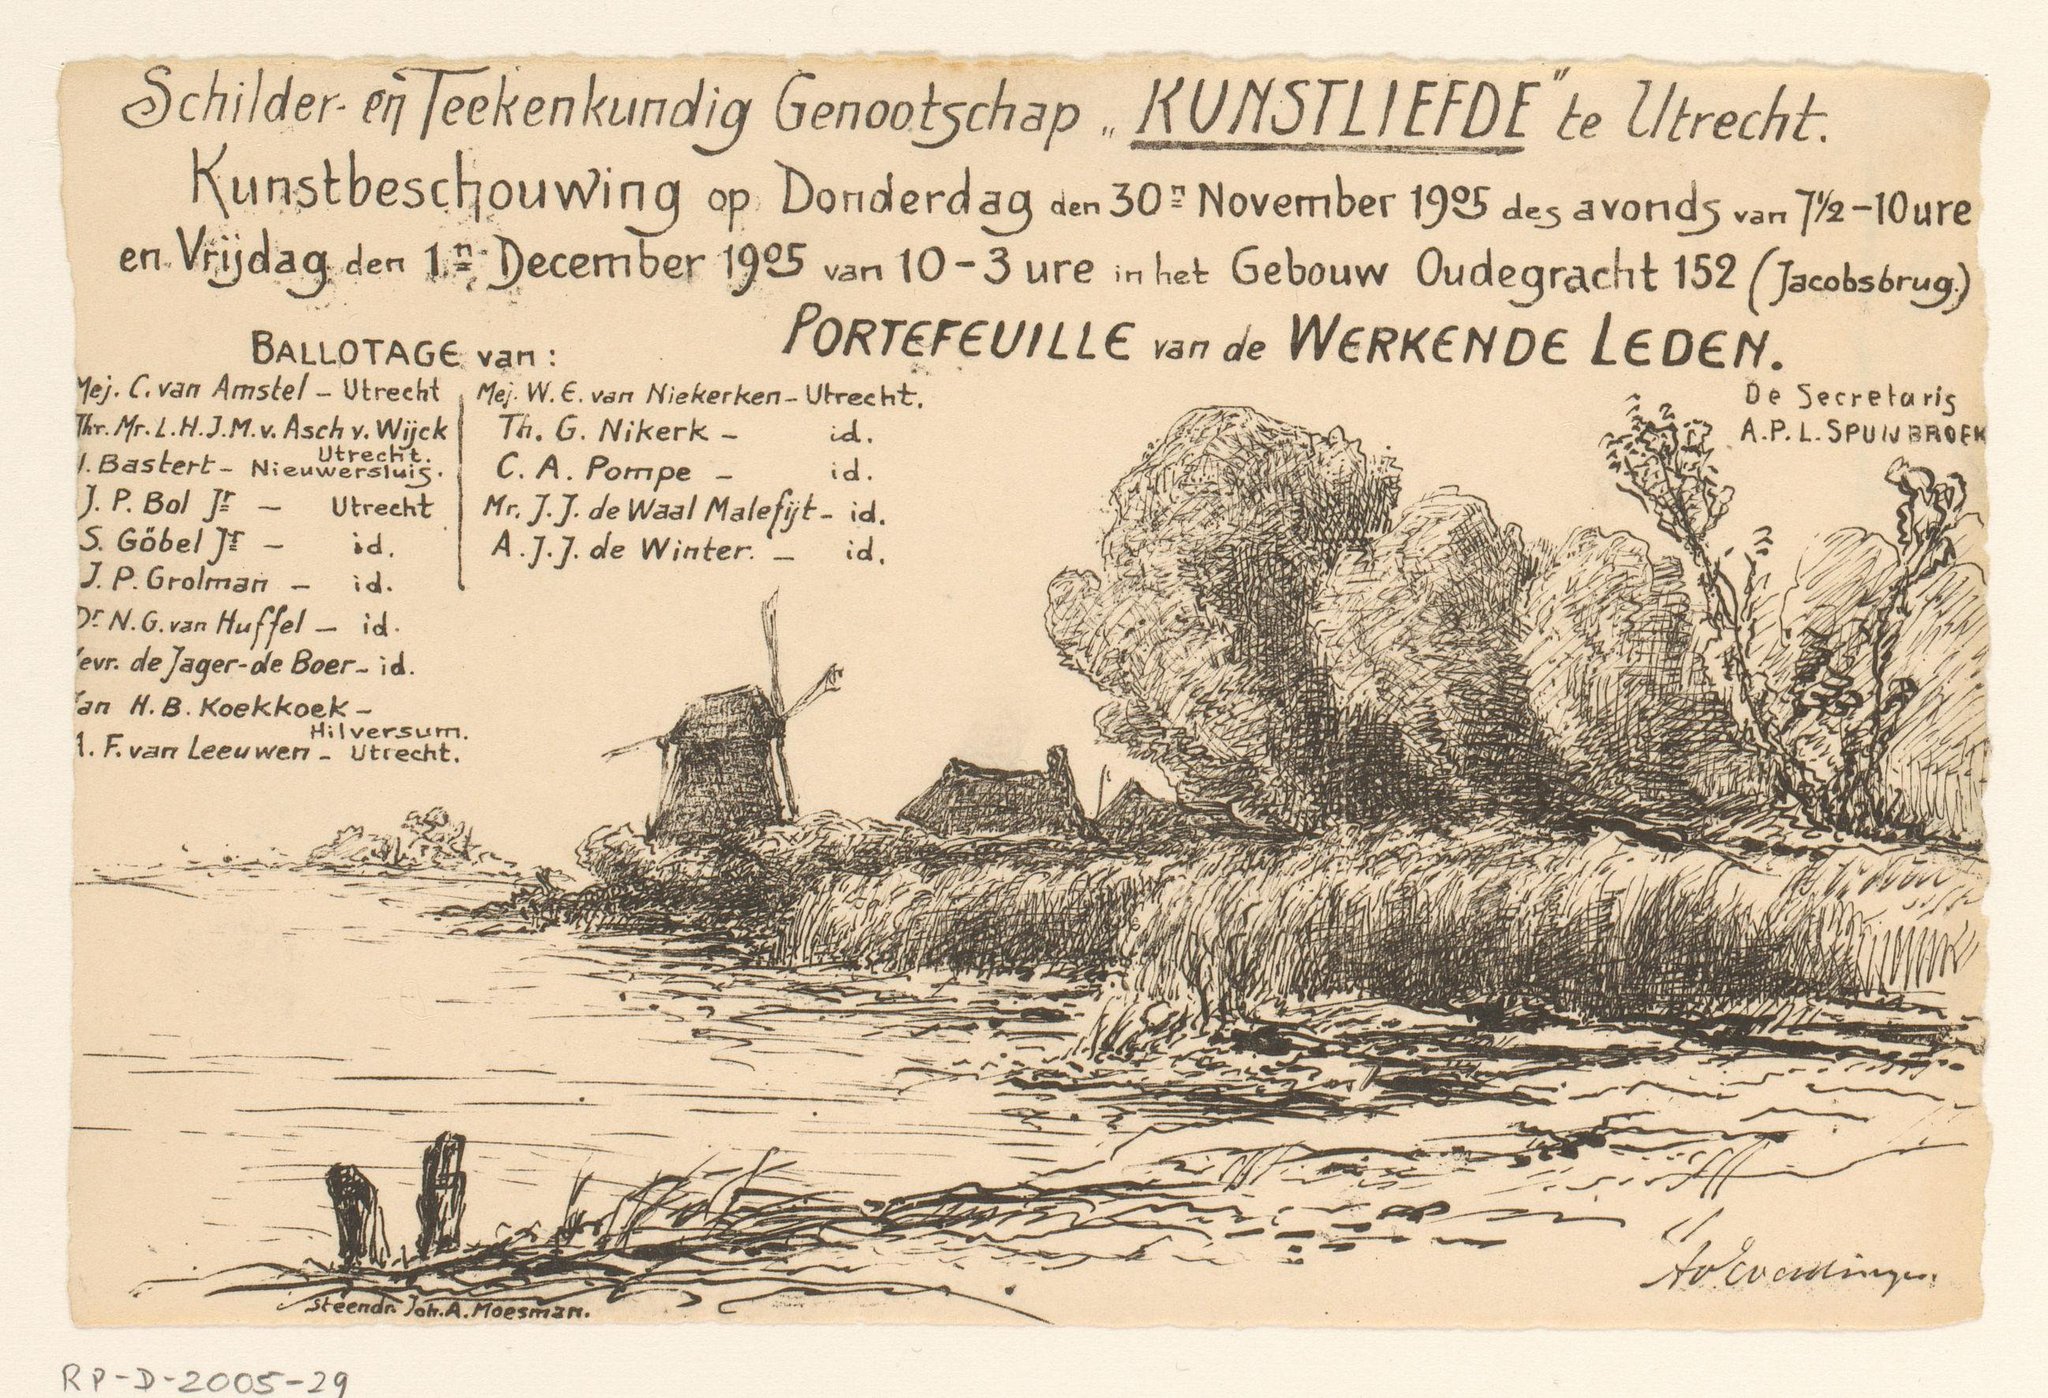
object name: print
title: Uitnodiging van Schilder- en Teekenkundig Genootschap "Kunstliefde" voor een kunstbeschouwing, 1 december 1905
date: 1905-1911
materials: paper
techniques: lithograph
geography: utrecht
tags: criticizing and discussing art, art criticism, circle, club of artists, collecting and exhibiting products of the fine arts, water course, windmill in landscape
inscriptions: collector's mark: Lugt 2228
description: Molen en boerderij aan de waterkant. Uitnodiging van Schilder- en Teekenkundig Genootschap "Kunstliefde" voor een kunstbeschouwing op 1 december 1905 van de portefeuille van de werkende leden, in het gebouw aan de Oudegracht 152.